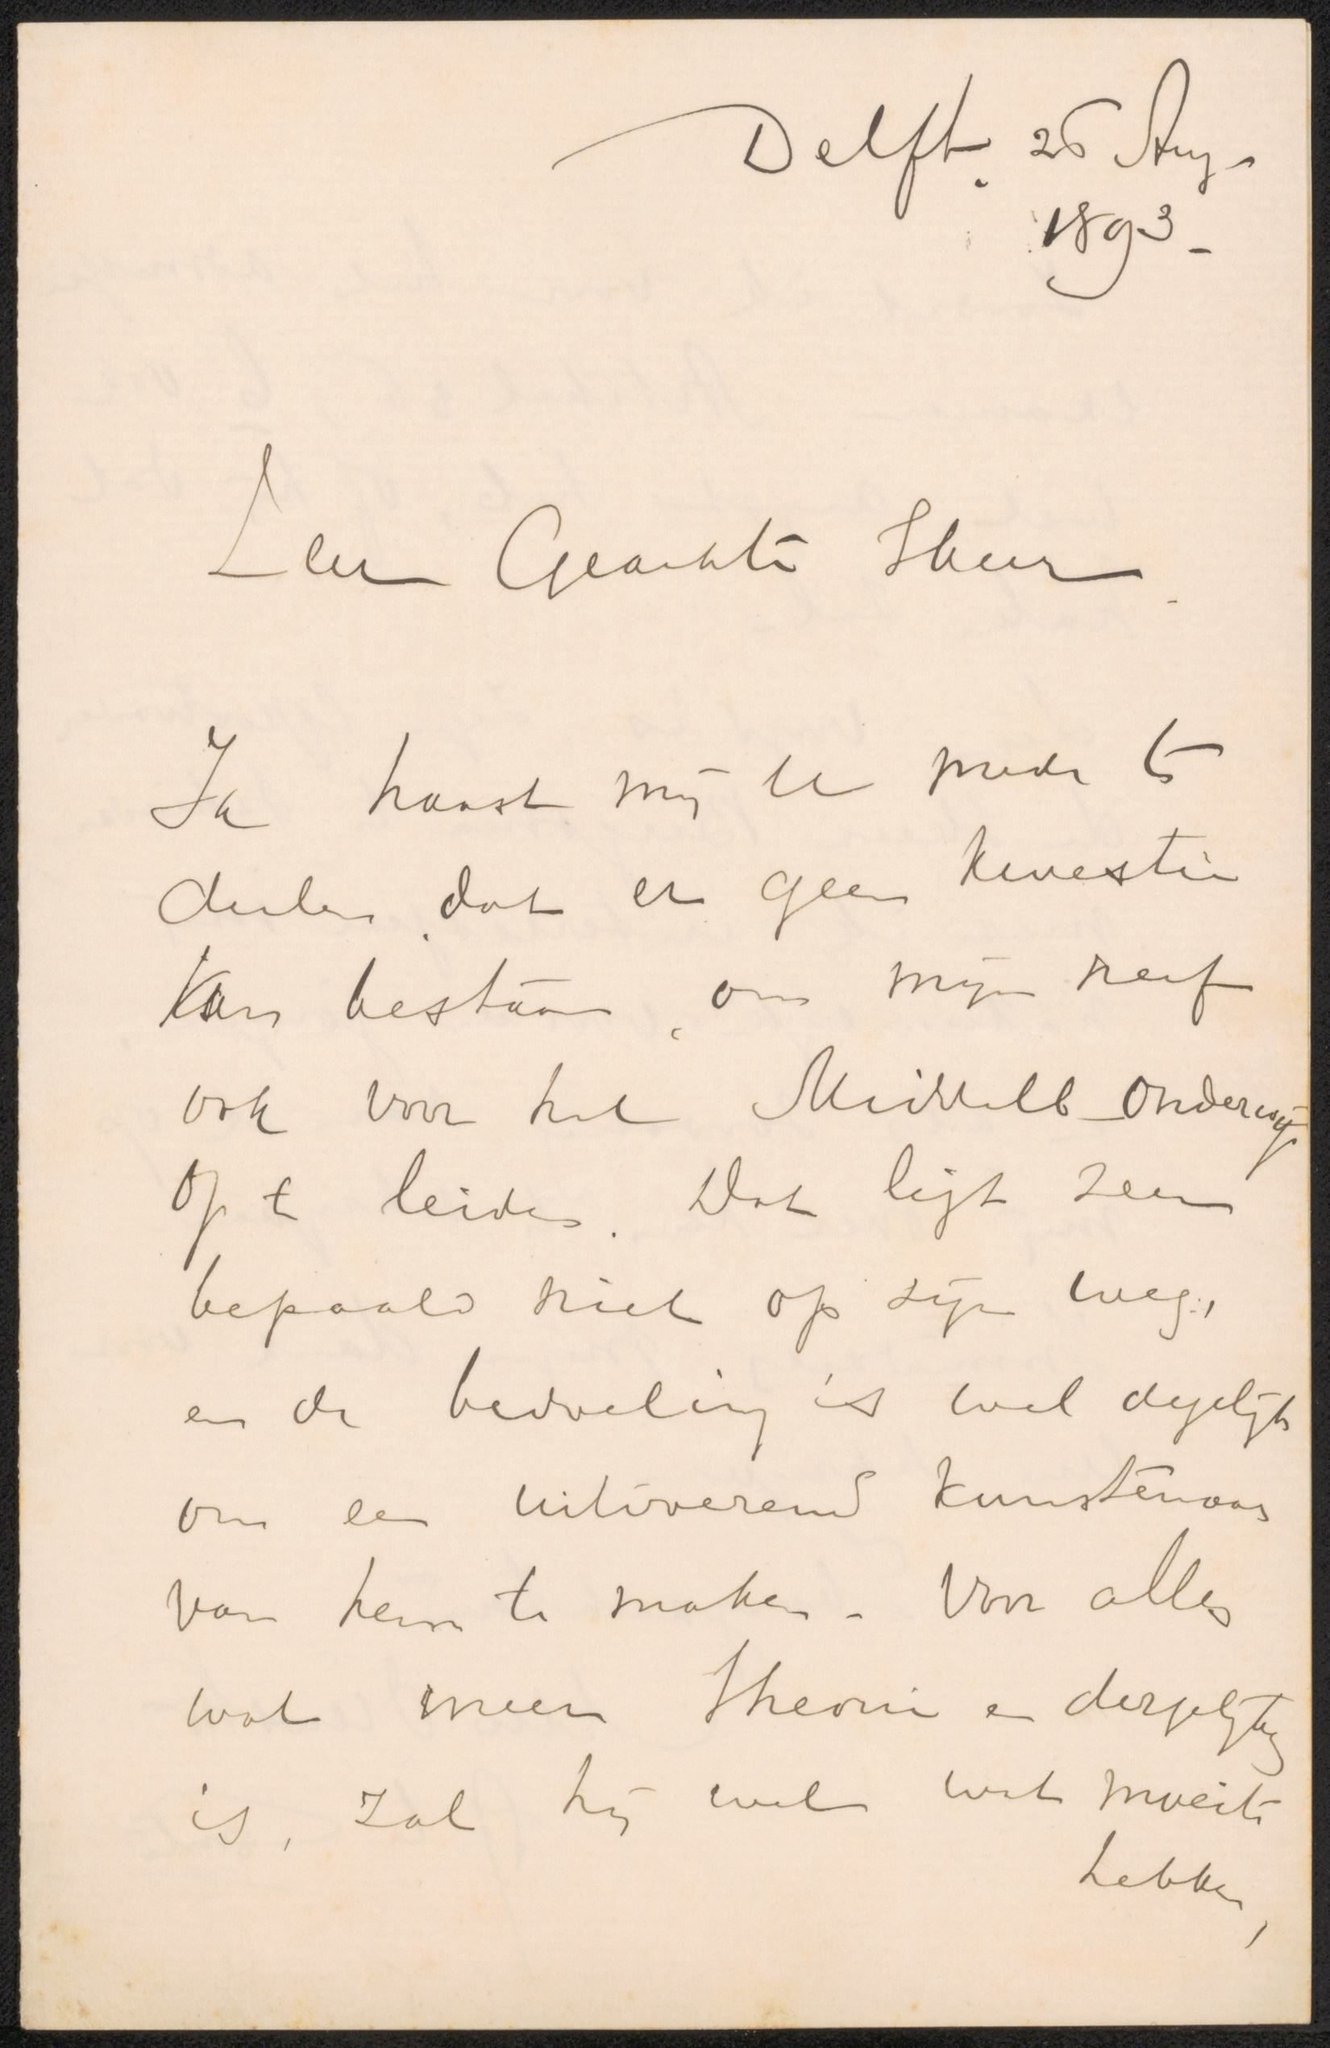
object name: letter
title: Brief aan August Allebé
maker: adolf le comte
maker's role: draughtsman, painter, print maker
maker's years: 1850-1921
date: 1893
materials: ink, paper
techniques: pen, writing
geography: delft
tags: august allebé, draughtsman, anton rudolf mauve, education, tuition of the artist (in general)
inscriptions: watermark